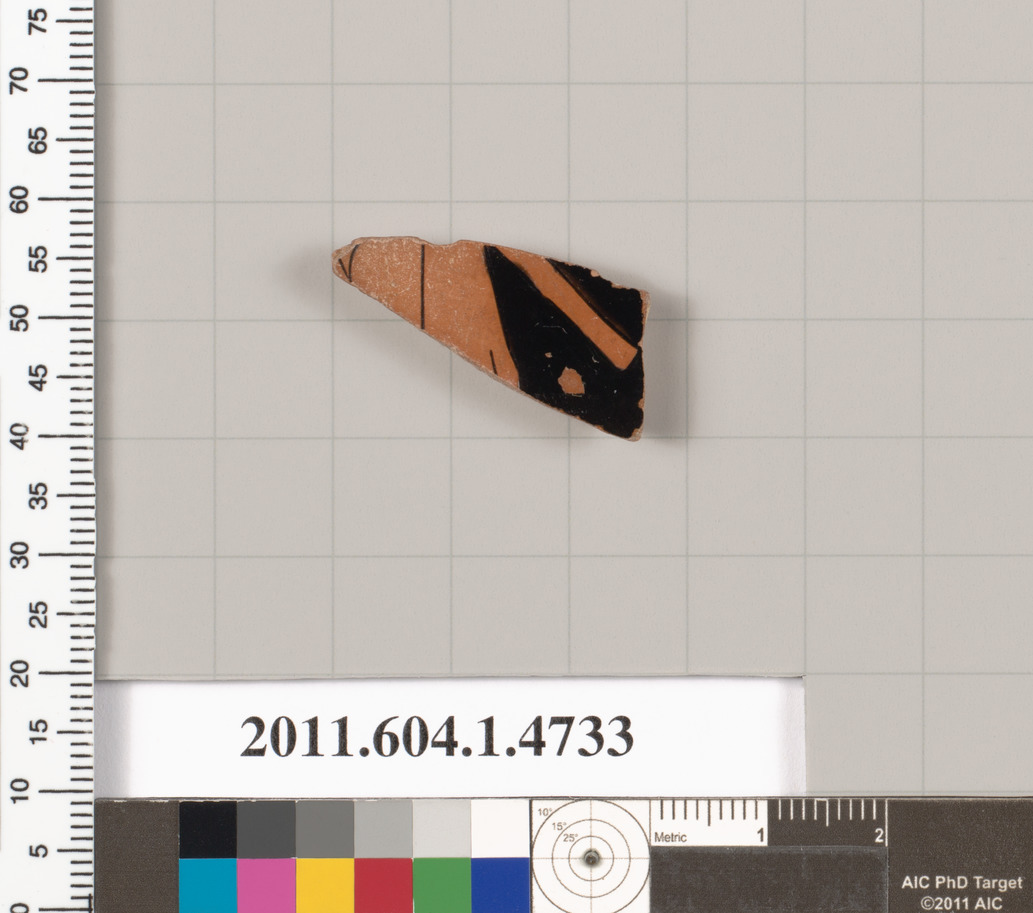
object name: kylix fragment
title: Terracotta fragment of a kylix (drinking cup)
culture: greek, attic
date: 475-451 BCE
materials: terracotta